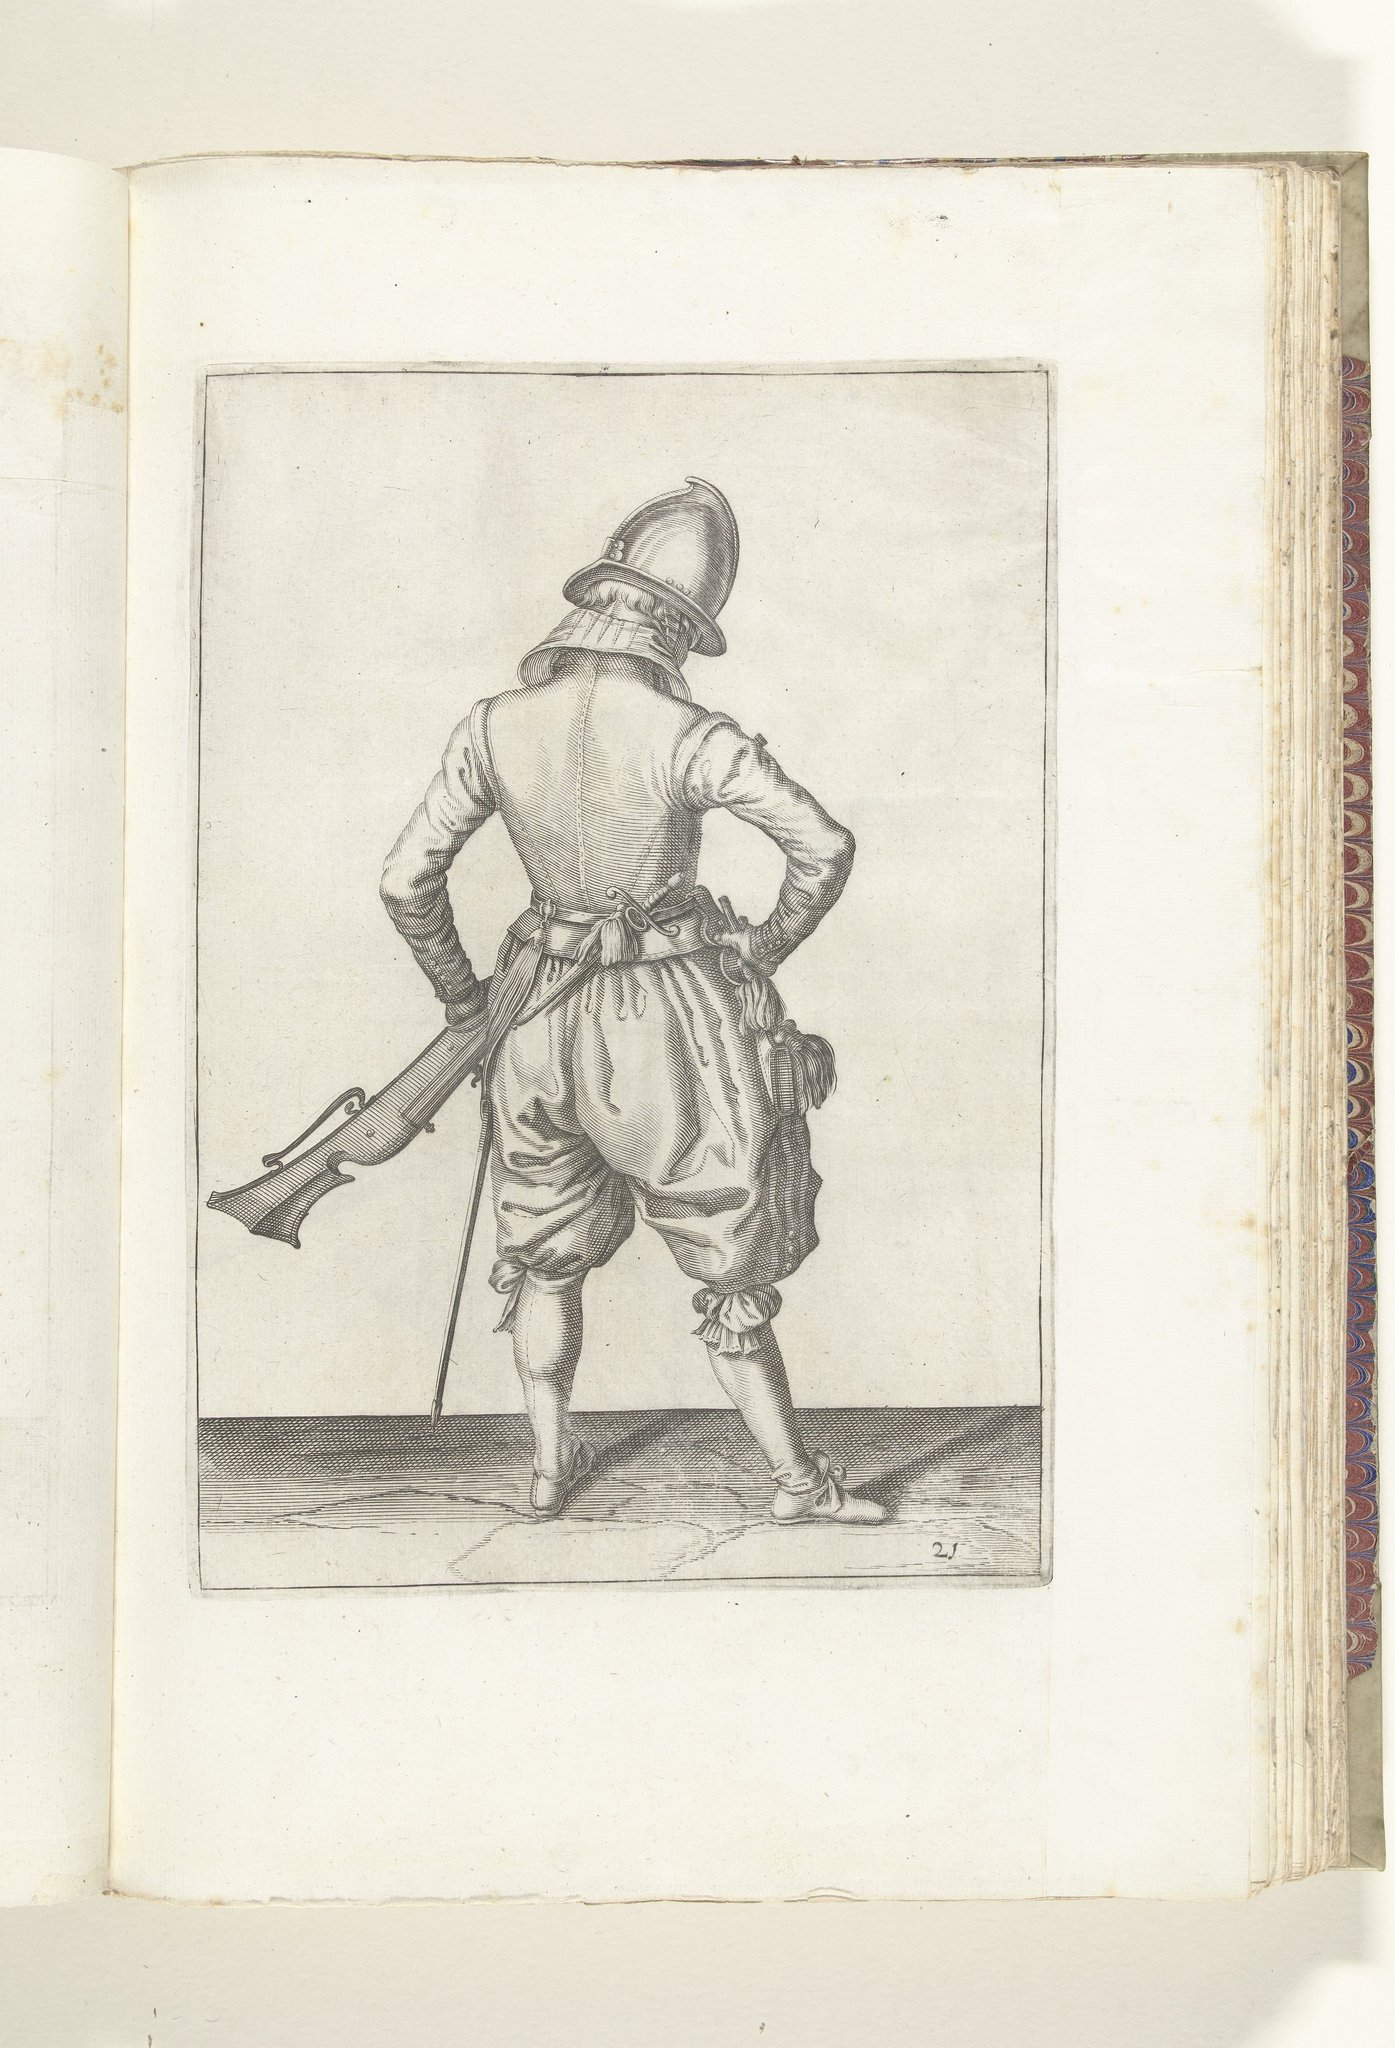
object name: print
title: Soldaat met een roer die zijn kruithoorn pakt (nr. 21), ca. 1600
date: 1597-1607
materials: paper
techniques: engraving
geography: northern netherlands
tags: maurice (prince of orange), handling of weapons ~ military training, weapons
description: Een soldaat, ten voeten uit, op de rug gezien, die met zijn linkerhand bij zijn linkerdijbeen een roer (een bepaald type vuurwapen) vasthoudt, de loop schuin omhoog wijzend (nr. 21), ca. 1600. Met zijn rechterhand pakt hij bij zijn zij een kruithoorn vast. Plaat 21 in de instructies voor het hanteren van de roer. Onderdeel van de illustraties in: J. de Gheyn, Wapenhandelinghe van Roers Musquetten ende spiessen, Amsterdam, 1608. Krijgswezen rond 1600.